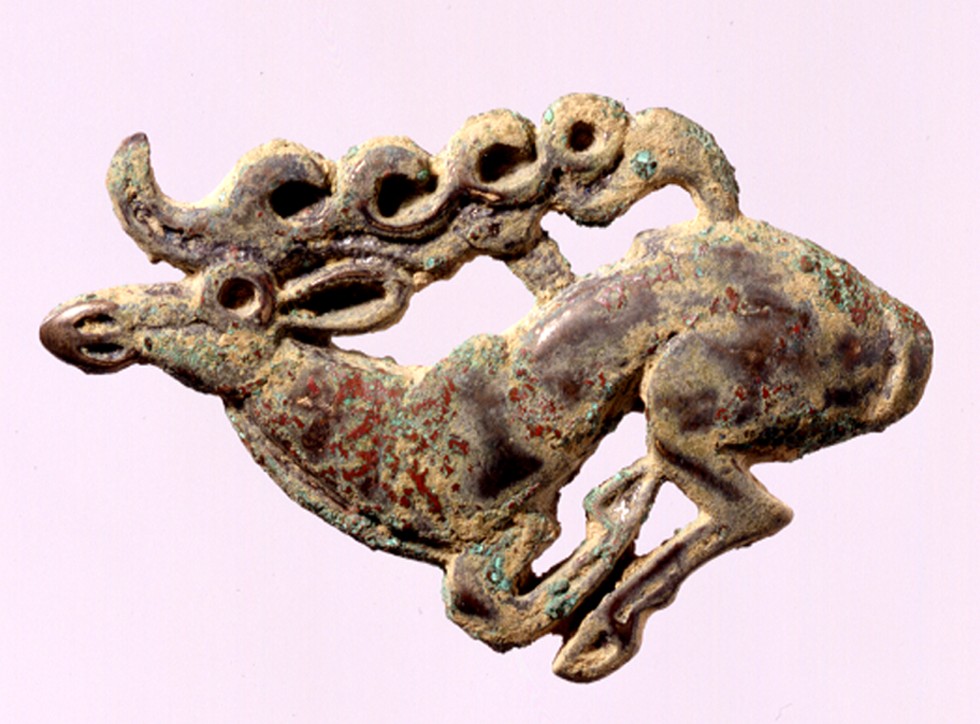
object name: garment plaque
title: Garment Plaque in the Shape of Deer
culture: kazakh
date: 600-301 BCE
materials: bronze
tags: deer